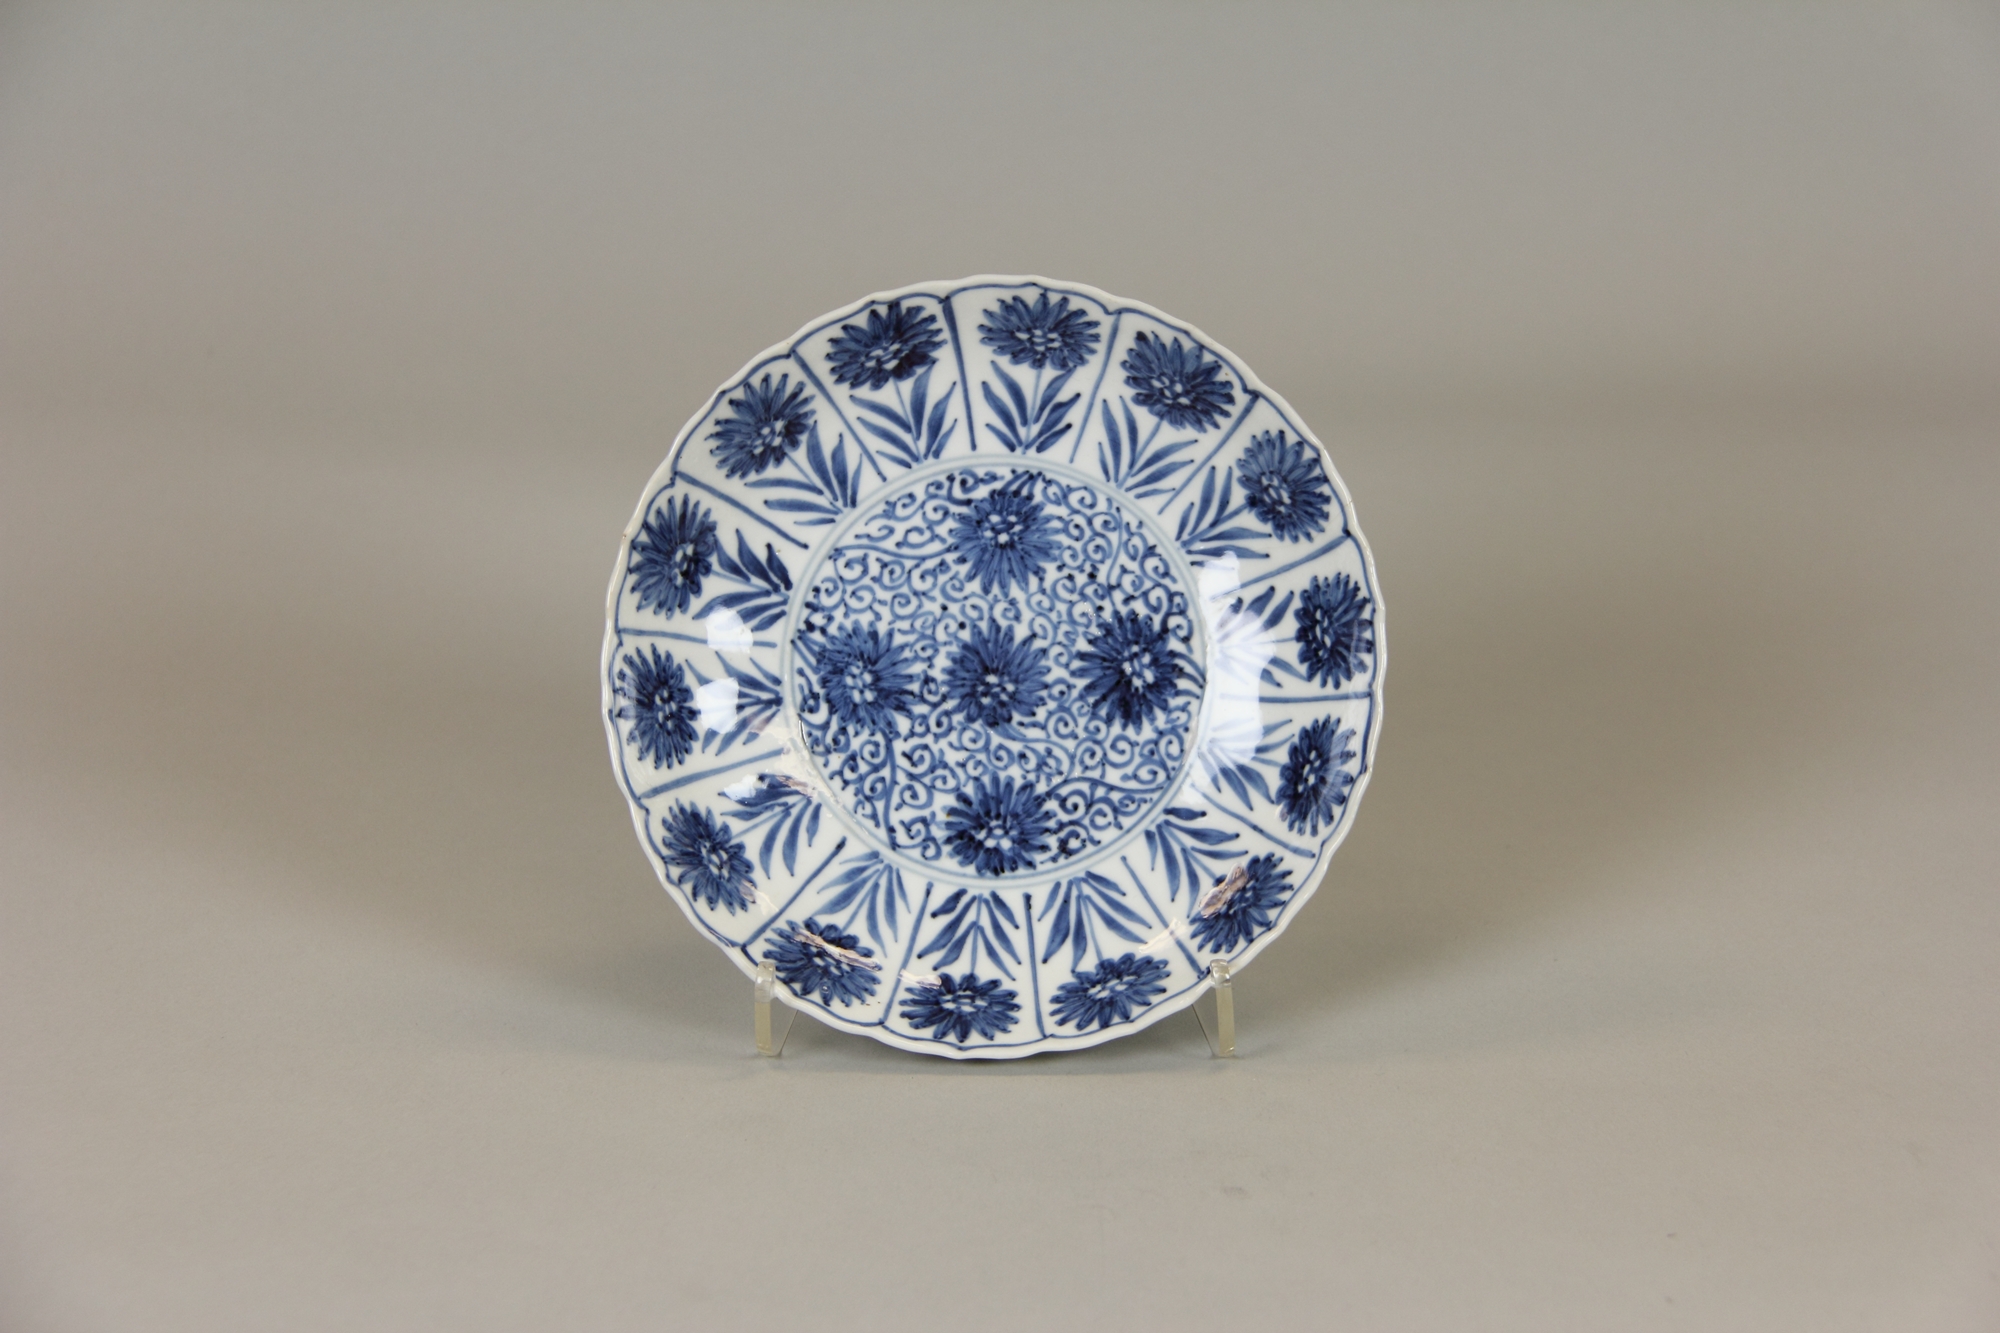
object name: dish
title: Dish with chrysanthemums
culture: chinese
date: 1667-1733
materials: cobalt, porcelain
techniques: painting, underglaze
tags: flowers